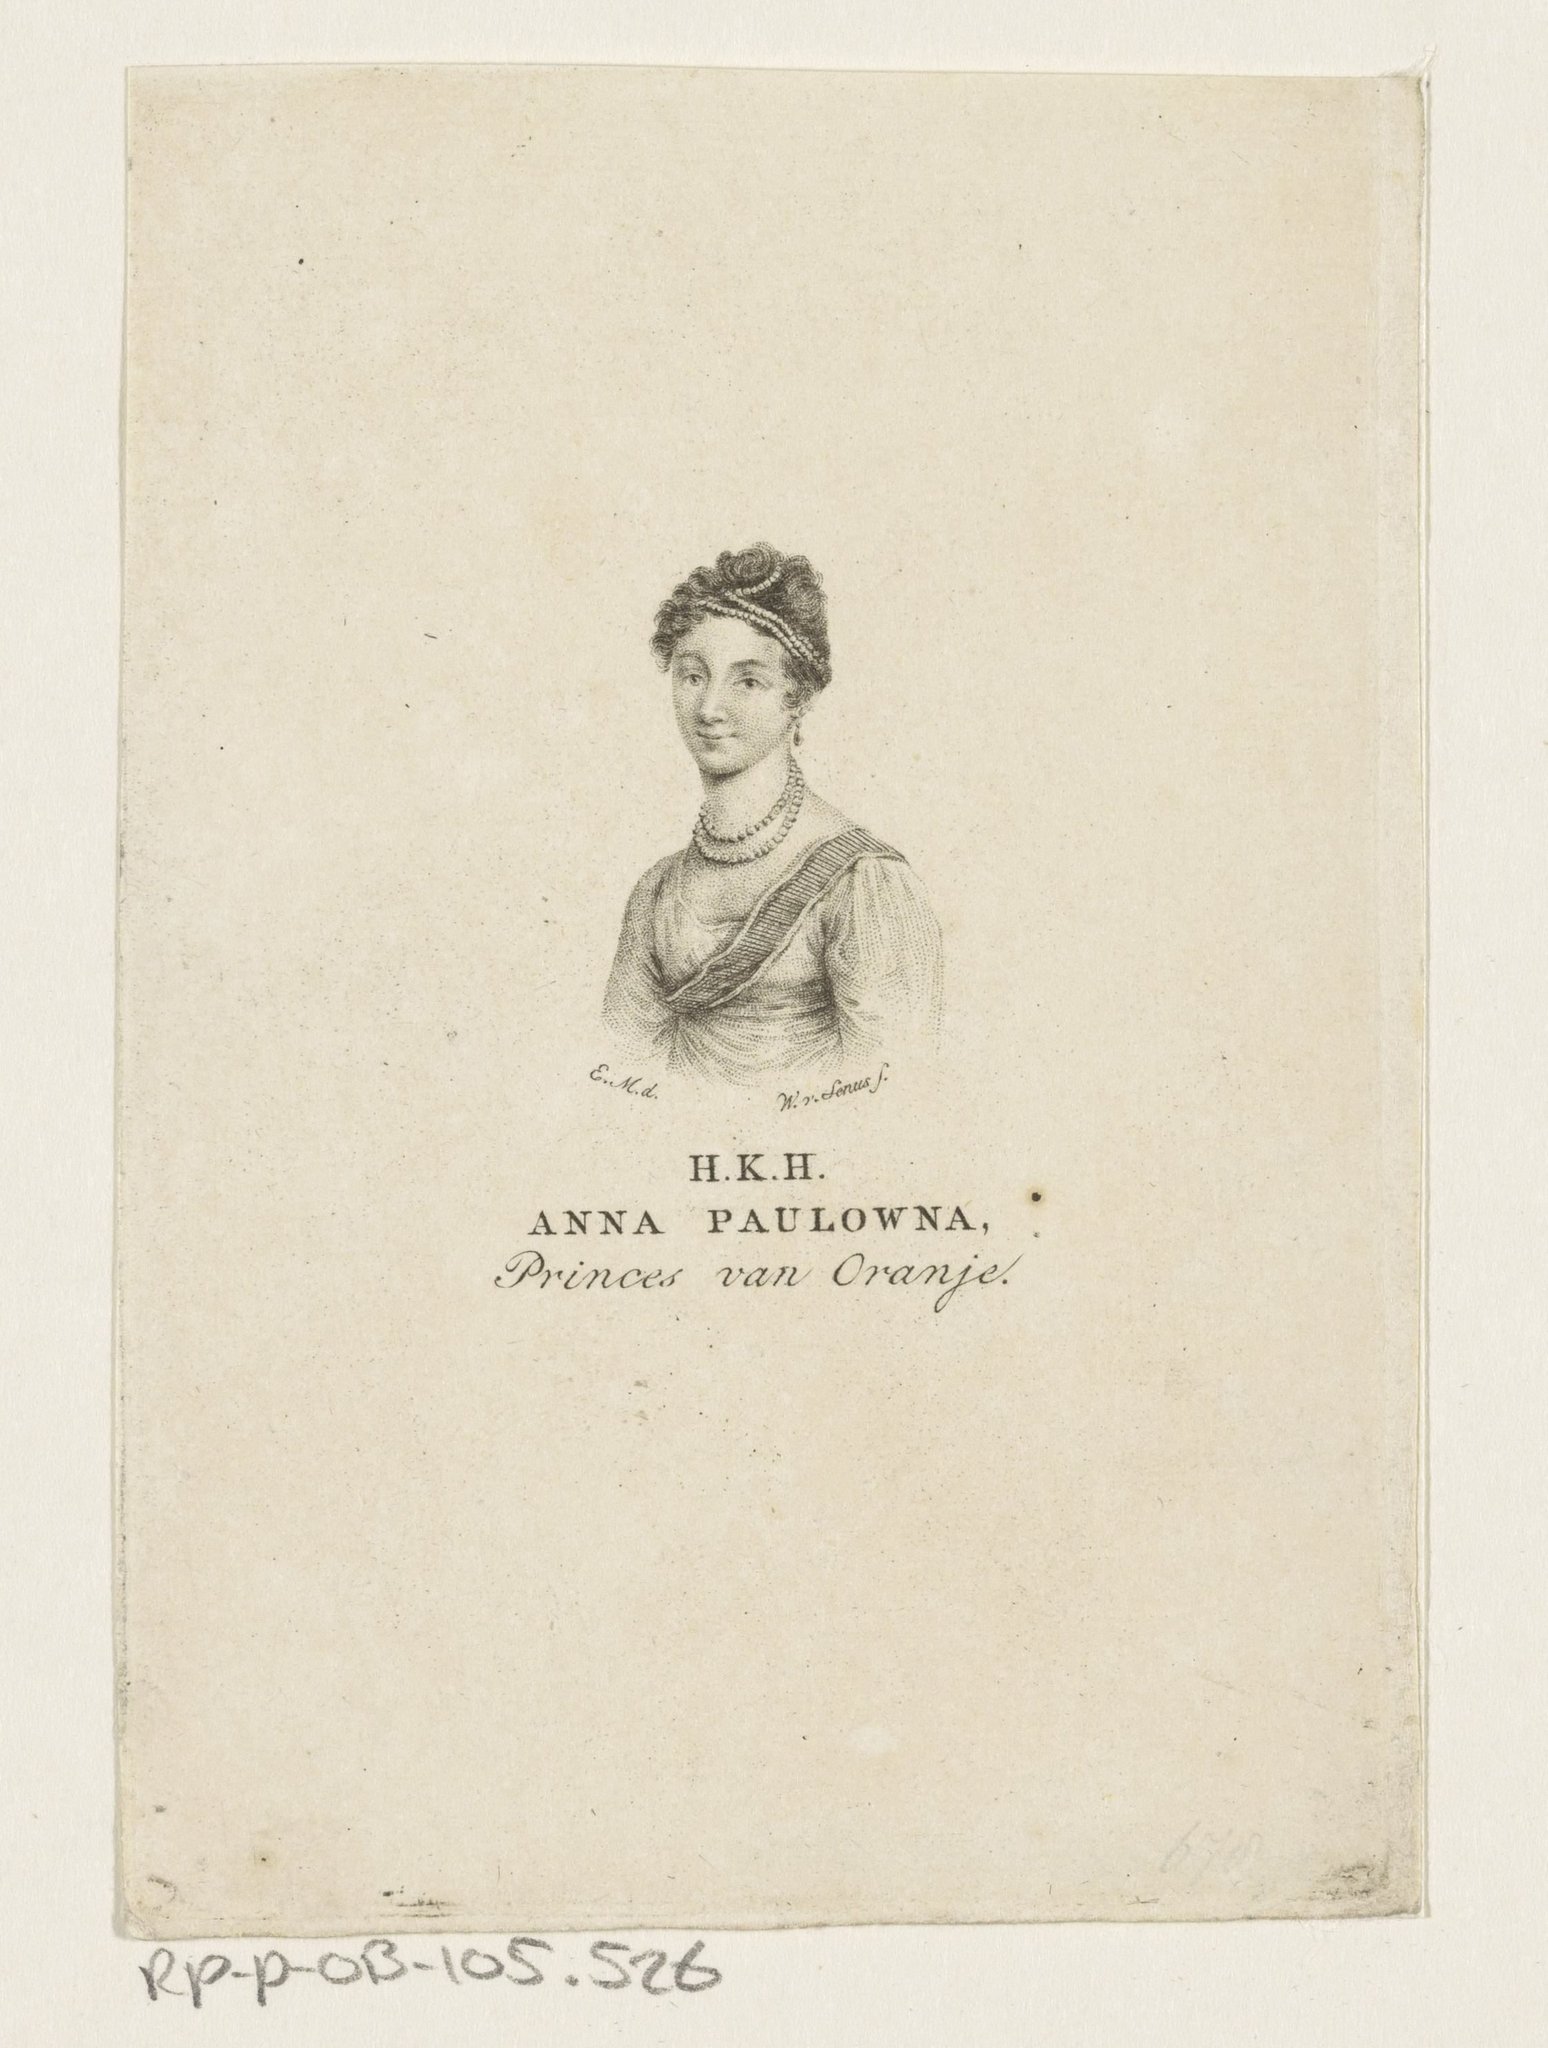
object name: print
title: Portret van Anna Paulowna Romanowa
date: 1816-1834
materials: paper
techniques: engraving, etching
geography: amsterdam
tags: anna paulowna romanowa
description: Portret van Anna Paulowna. In de ondermarge haar naam en titel.